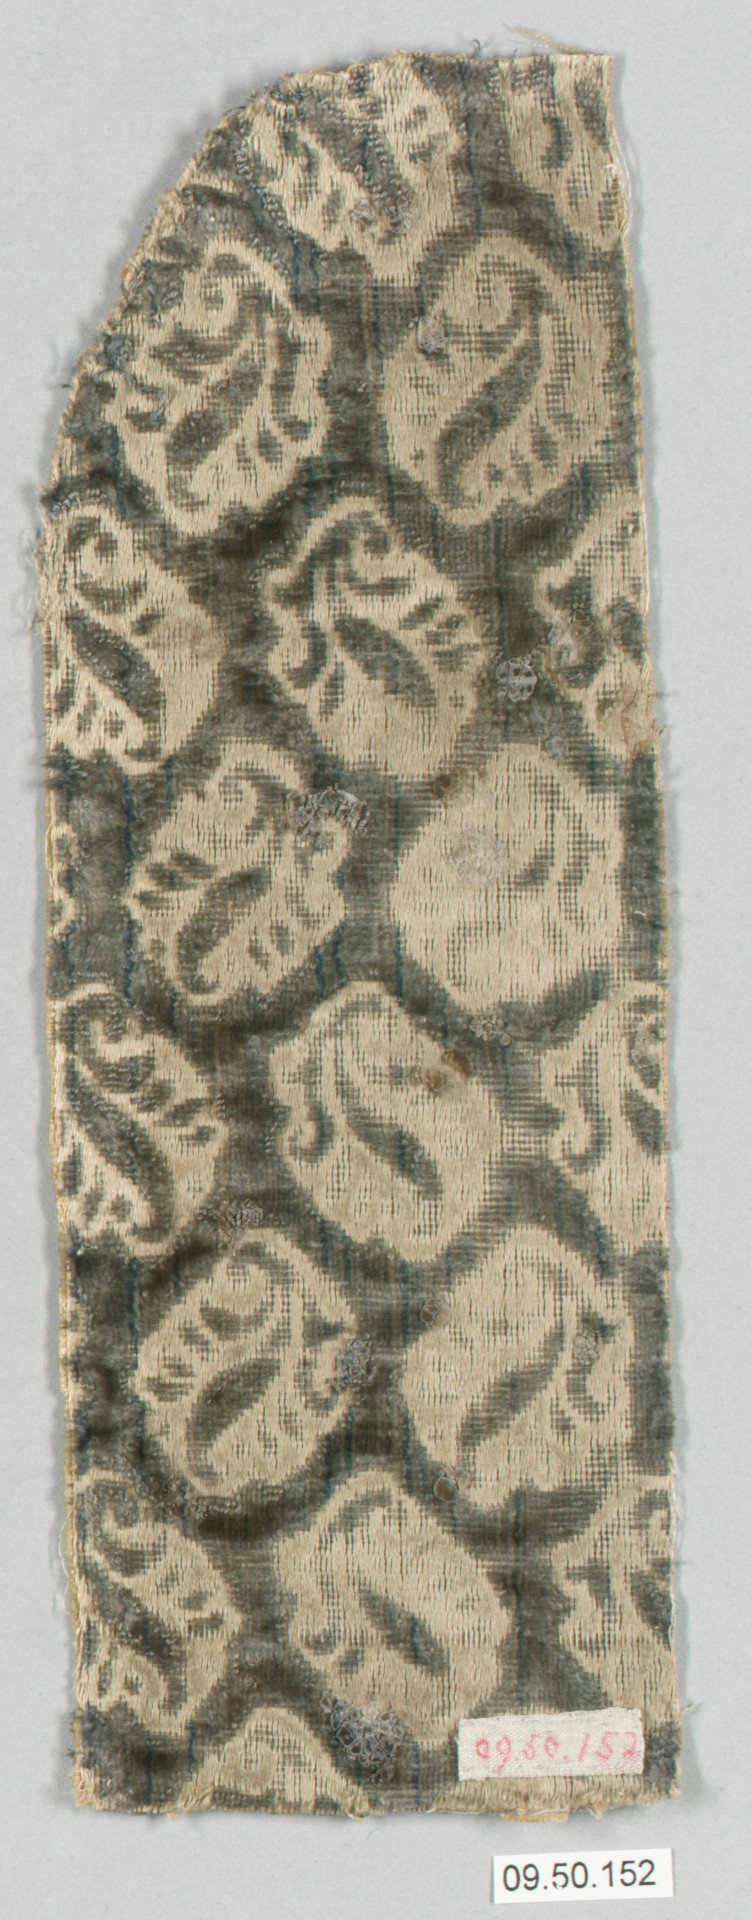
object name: piece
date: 1501-1700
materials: silk